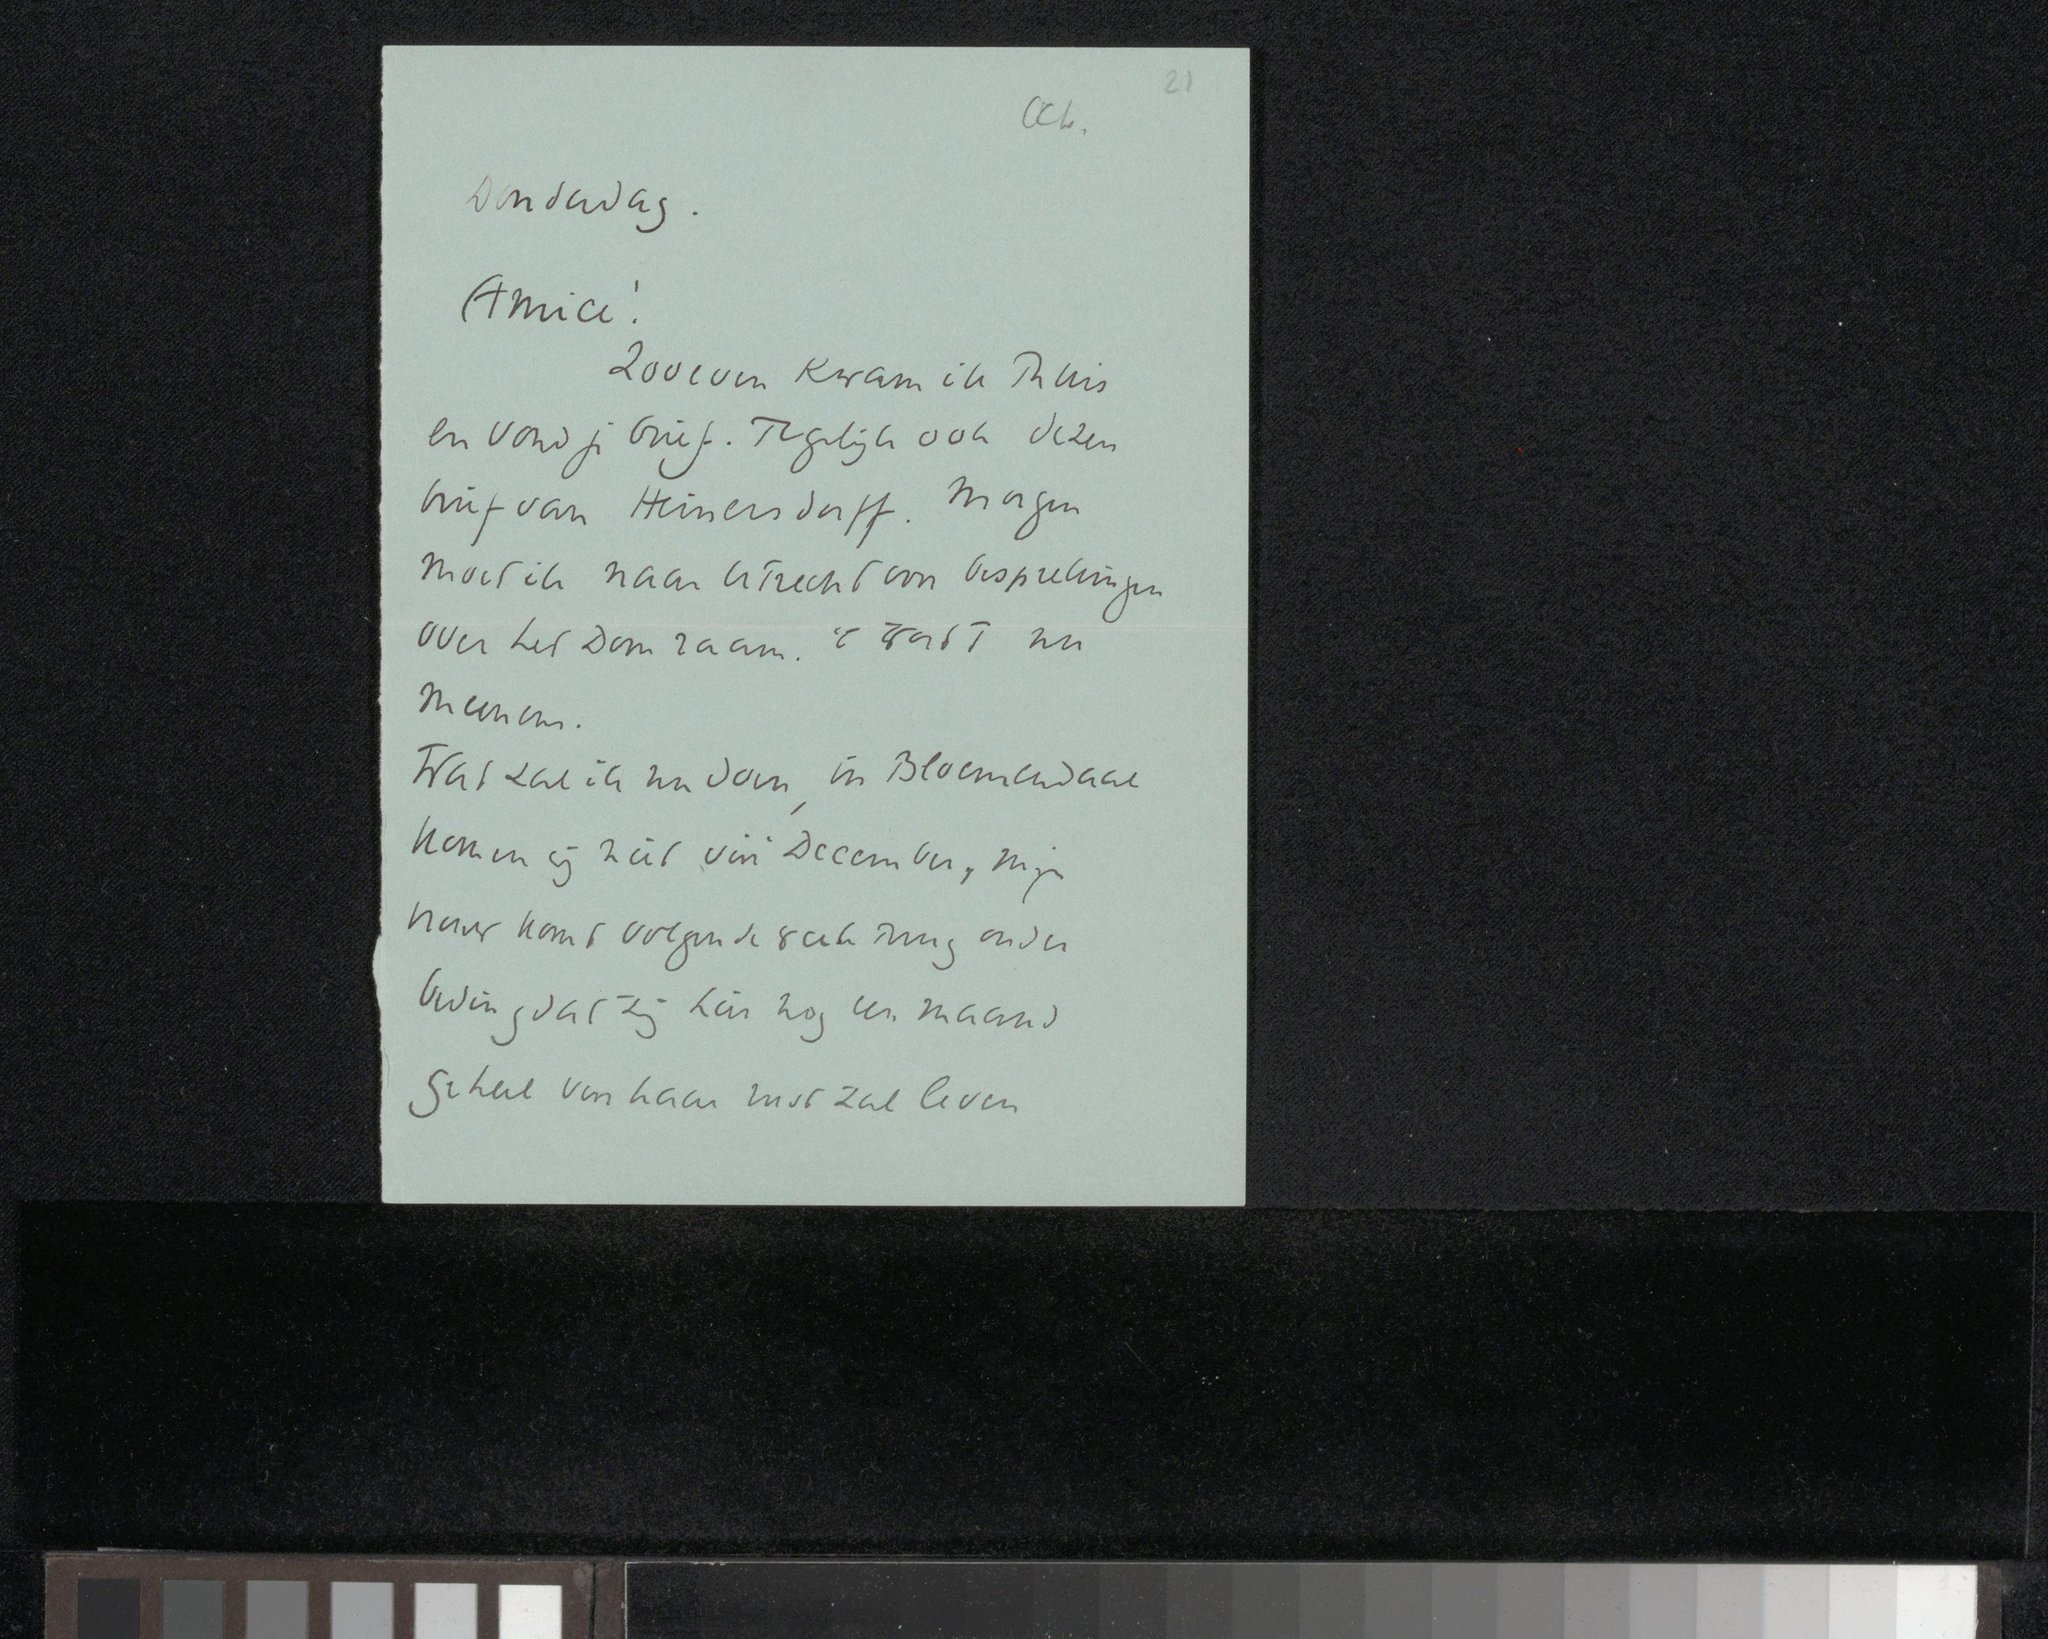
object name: letter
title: Brief aan Willem Bogtman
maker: richard nicolaüs roland holst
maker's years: 1868-1938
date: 1923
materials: ink, paper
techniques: pen, writing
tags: haarlem, willem bogtman, henriëtte roland holst-van der schalk, applied arts, arts and crafts; industrial design, berlin